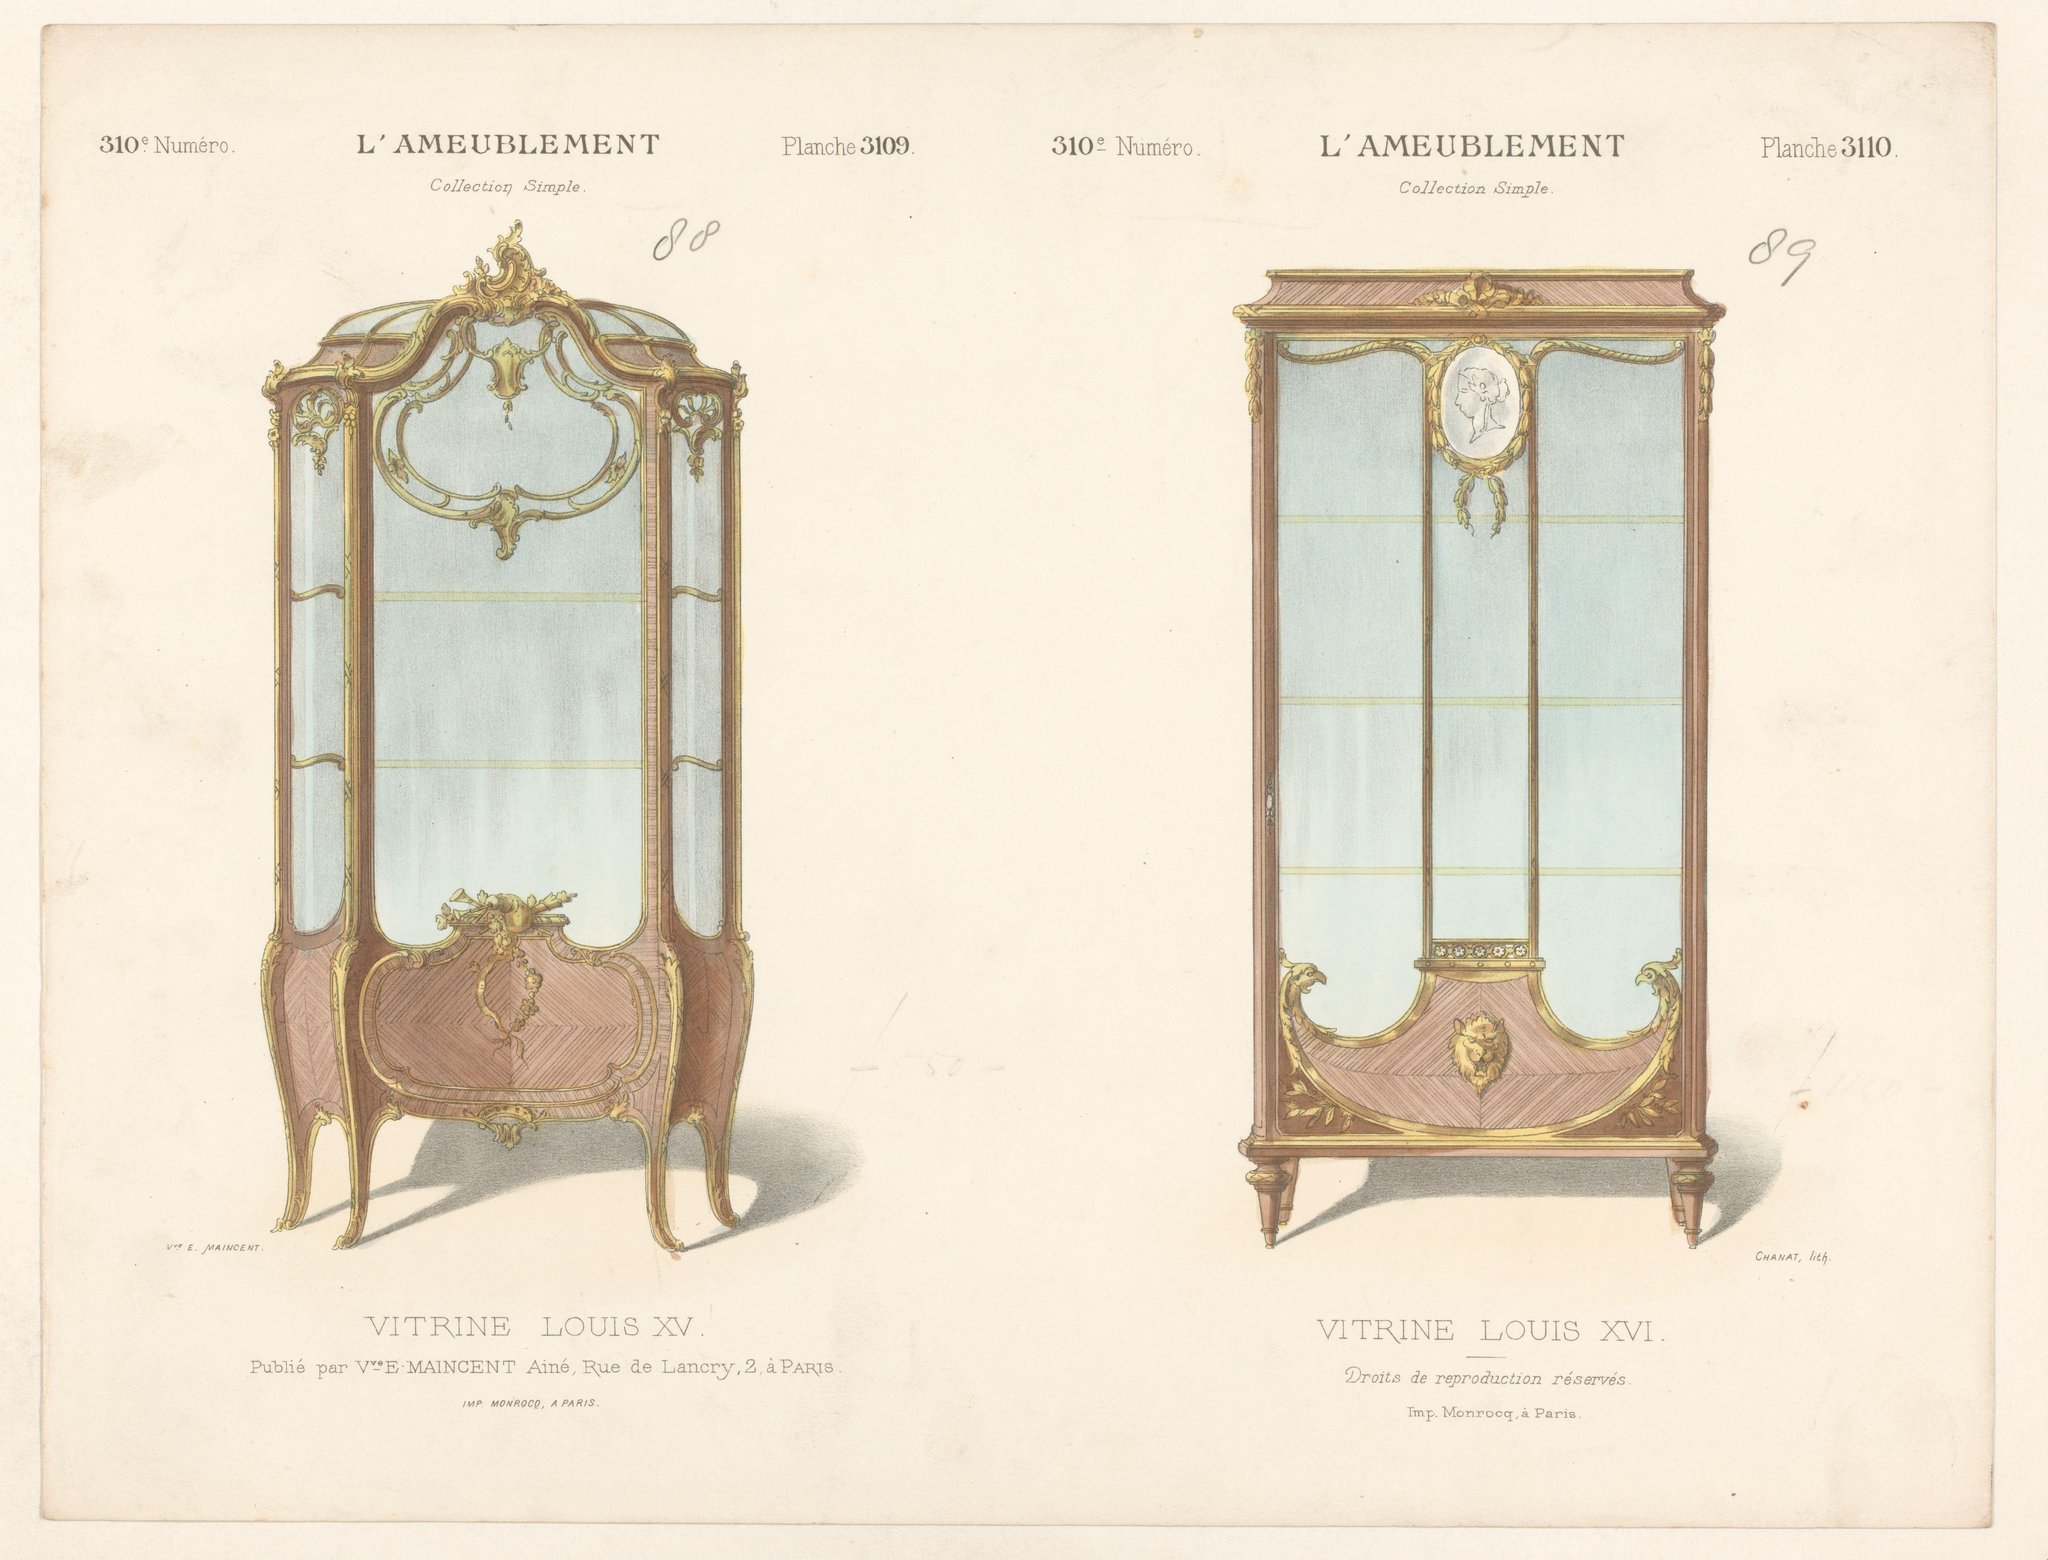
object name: print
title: L'ameublement / Collection Simple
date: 1895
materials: paper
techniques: hand coloring, lithograph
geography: paris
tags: furniture for storage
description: Twee vitrinekasten in de stijlen van Lodewijl XV en Lodewijk XVI. Prent uit 310e Livraison.